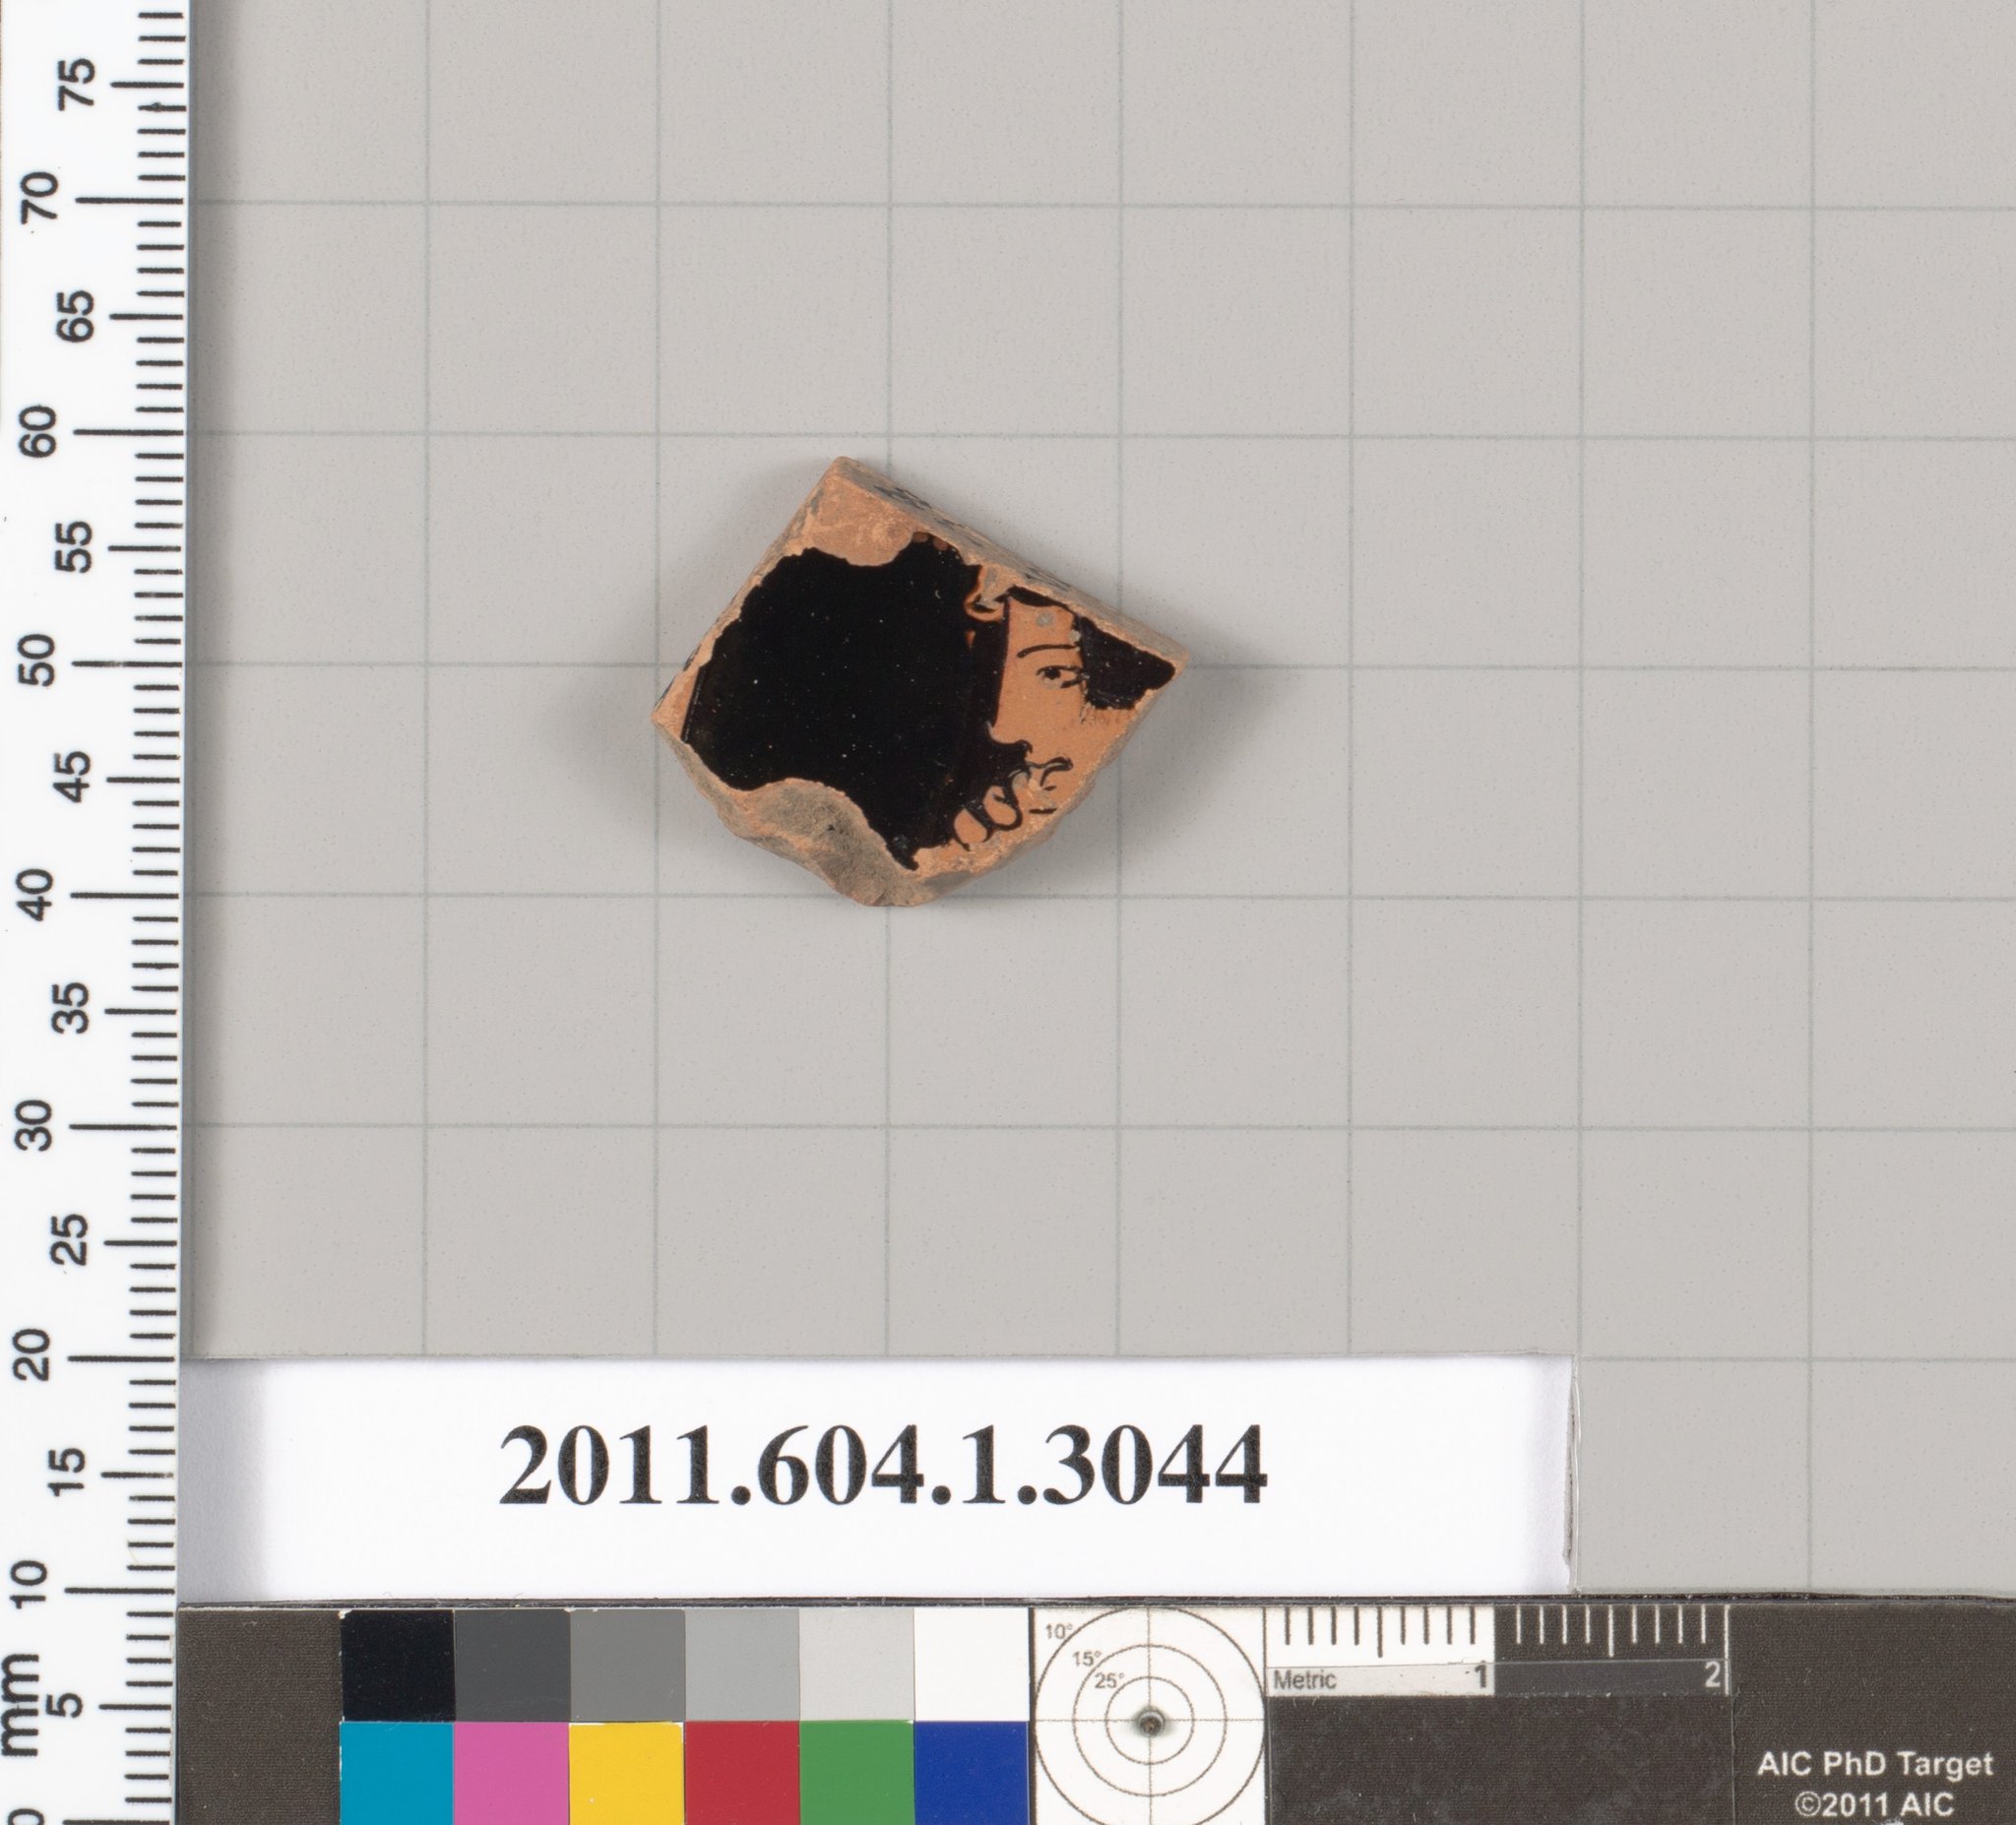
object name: kylix fragment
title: Terracotta fragment of a kylix (drinking cup)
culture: greek, attic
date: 480-460 BCE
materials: terracotta